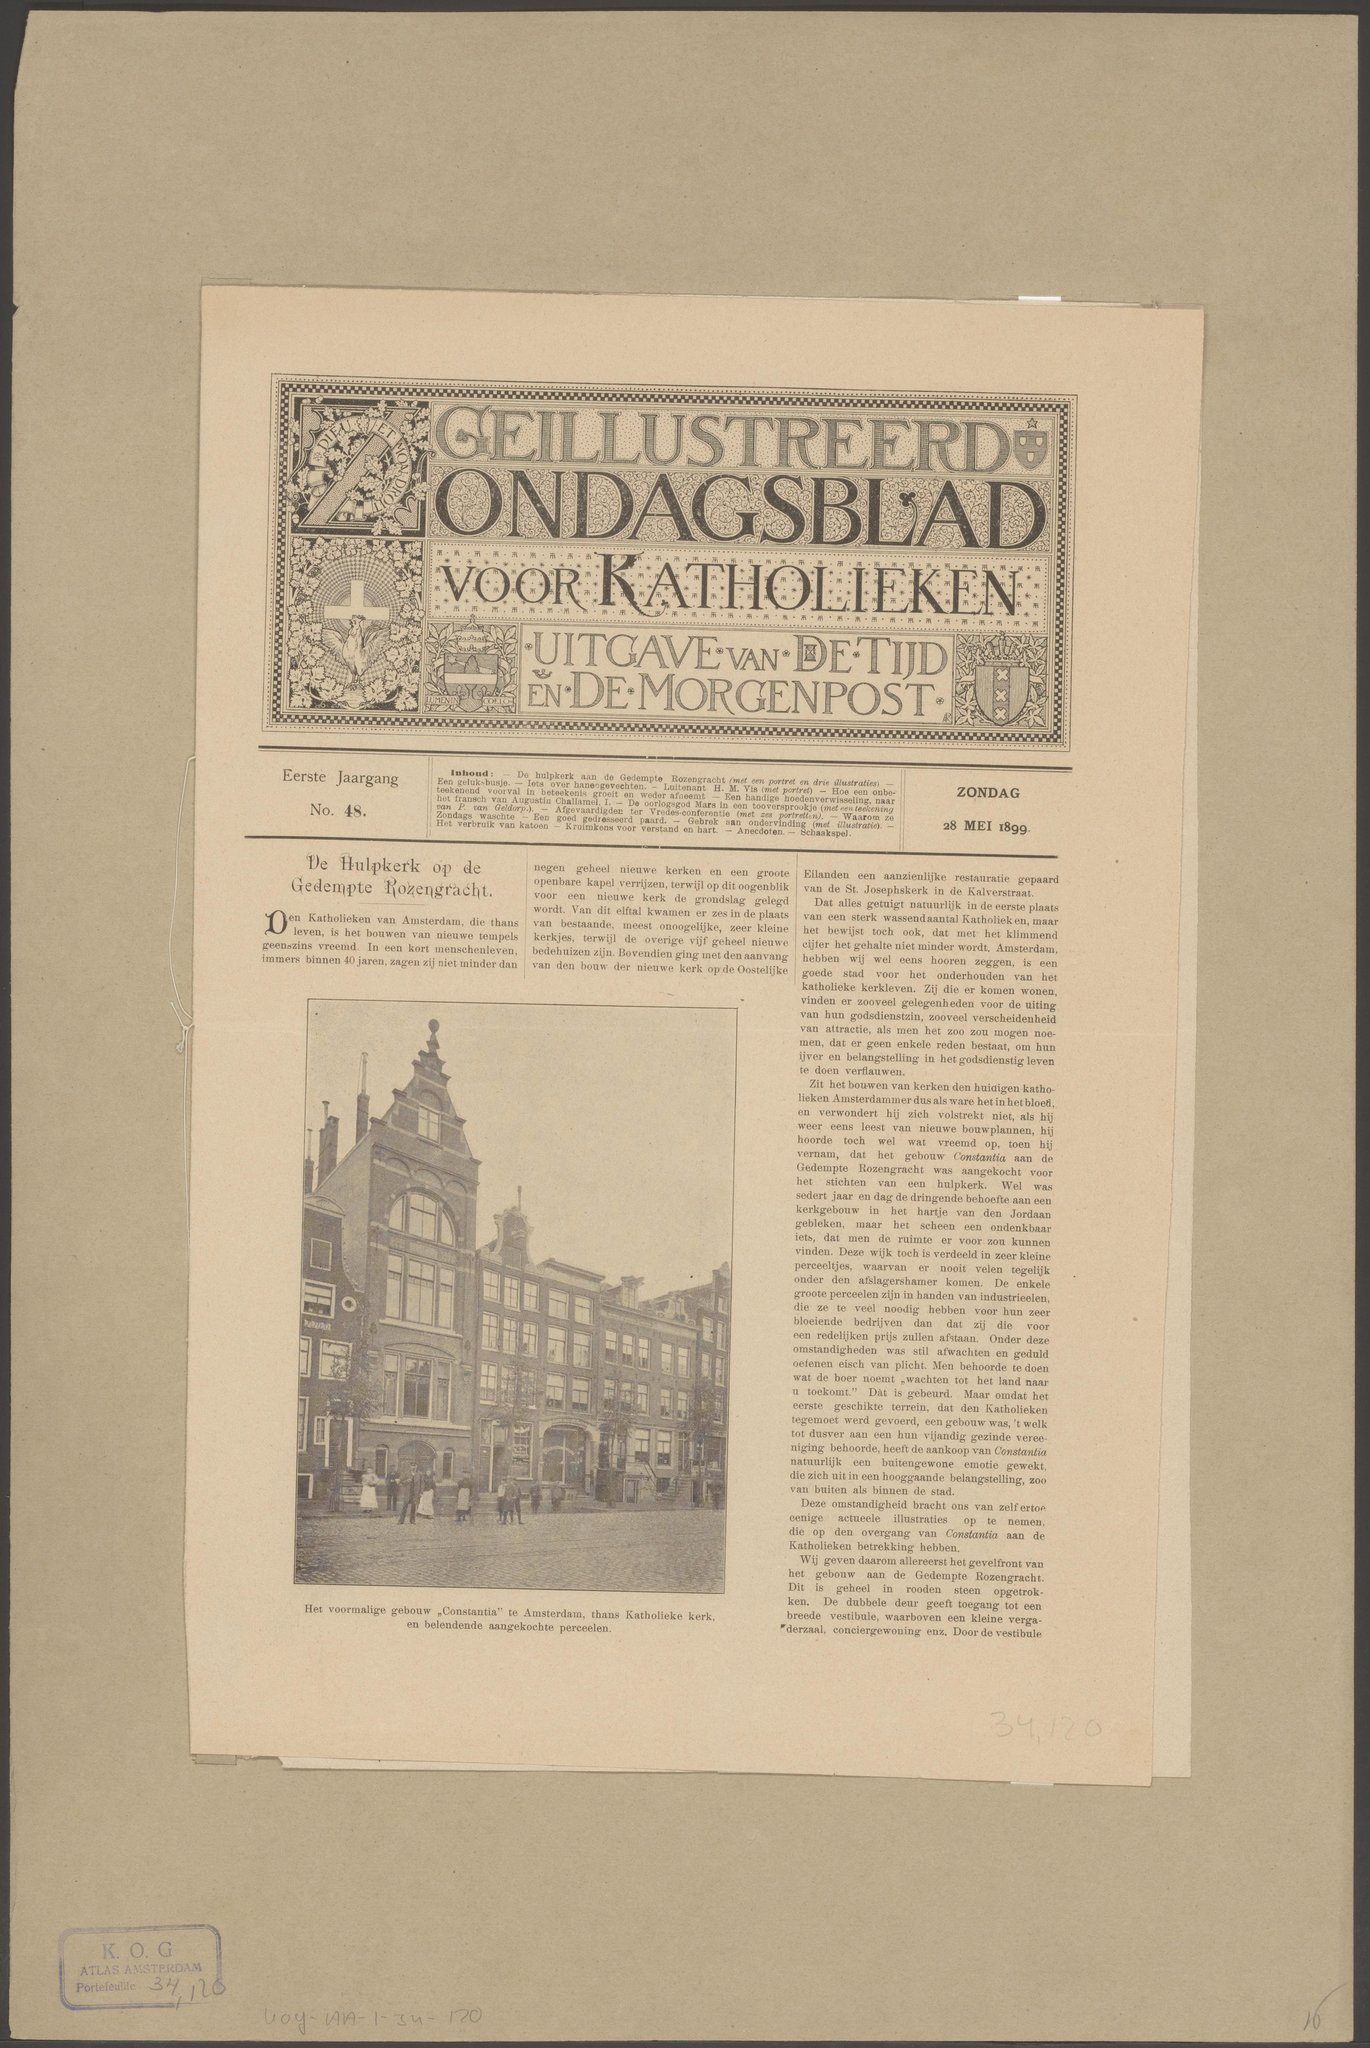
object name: photomechanical print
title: Titelpagina voor: Geïllustreerd Zondagsblad voor Katholieken, 28 mei 1899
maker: Anonymous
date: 1899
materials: paper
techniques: letterpress printing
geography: amsterdam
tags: joannes carolus alberdingk thijm (jan), surabaya, meeting, assembly, historical persons, floor plan ~ architectural design or model, holy mass (divine service, especially of roman catholic church), street (+ city(-scape) with figures, staffage)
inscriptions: collector's mark: Lugt 1641b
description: Object bestaat uit twee aan elkaar gebonden bladen. Naast het gezicht op gebouw Constantia ook fotomechanische afdrukken van een vergadering van socialisten in hetzelfde gebouw op 16 april 1899, een portret van Joannes Carolus Alberdingk Thijm, een plattegrond van het gebouw Constantia als rooms-katholieke kerk, de eerste misviering in diezelfde kerk en een niet gerelateerd portret van luitenant Henri Mari Vis. Onderwerpsrubriek binnen de Atlas Amsterdam: Kerkwezen: R.K. Gemeenten: Begijnhof t/m Petrus en Paulus.